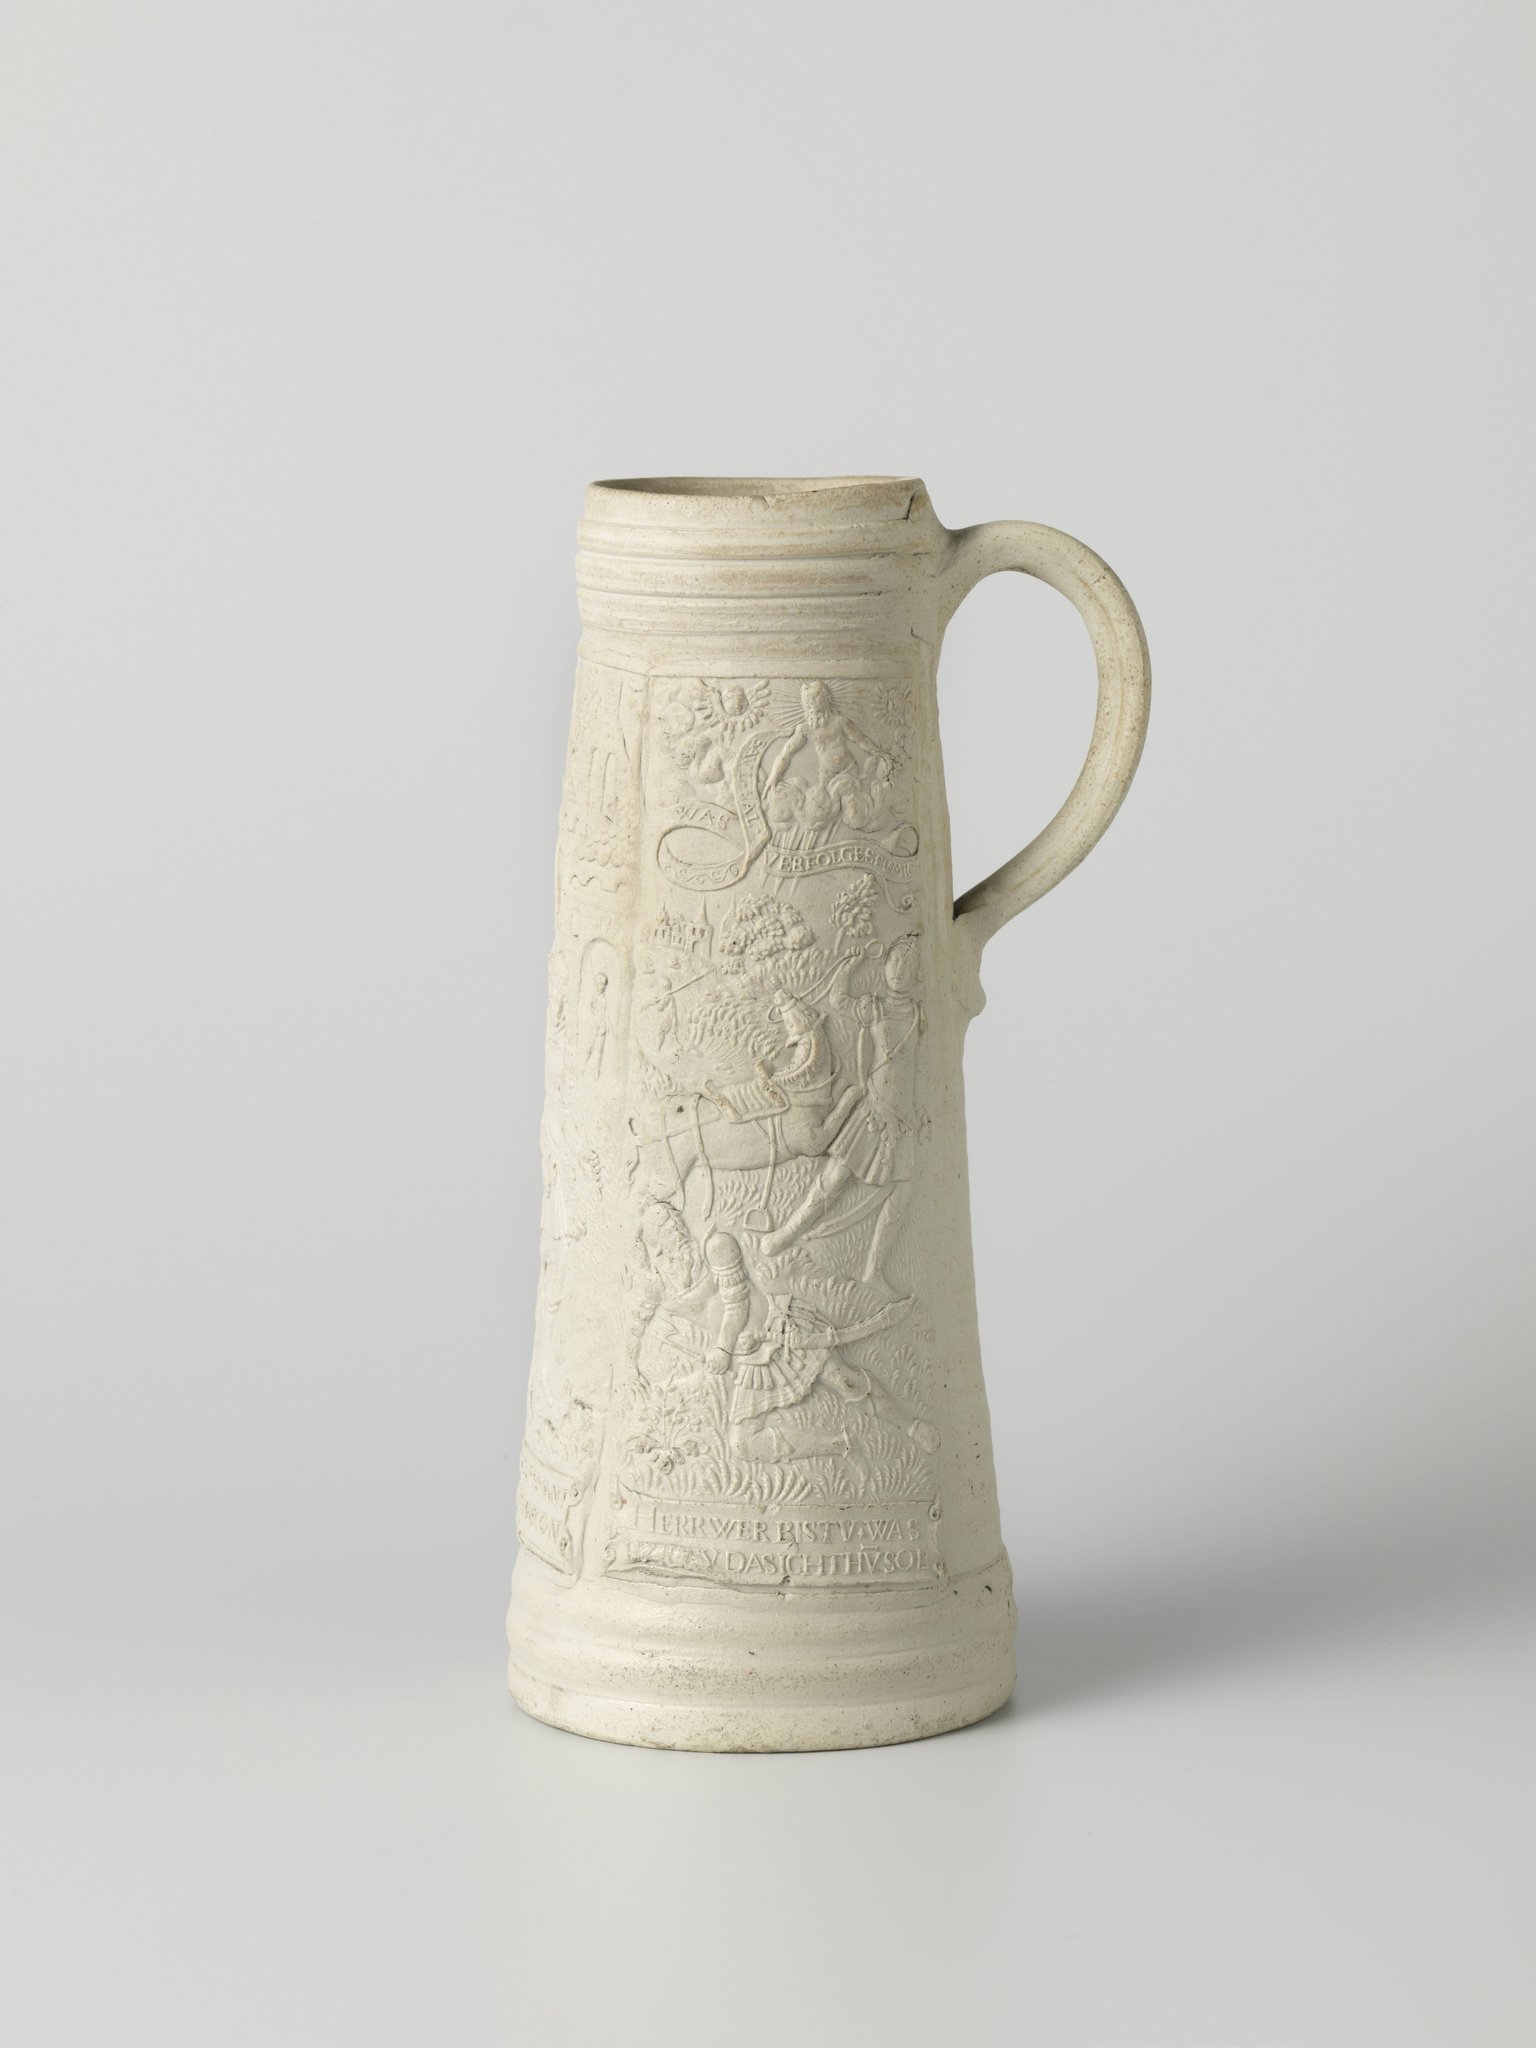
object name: jug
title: Fragment of a tankard (schnelle) with the Conversion of Paul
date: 1560-1565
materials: glaze, stoneware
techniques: firing, forming, relief, turning, vitrification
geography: siegburg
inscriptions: inscription: ‘HERR WER BISTV WAS WILTV DAS ICH THV SOL/ SAVL SAL WAS VERFOLGESTV MICH/ SIE NAME IN BEI DER HANT VD FVRETE INGE DAMASCON’, mark: ‘FT’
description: Fragment van een kruik (schnelle) van steengoed met cilindervormig, taps toelopend lichaam en C-vormig oor. Profielen onder de rand en boven de voet. Op het lichaam in reliëf driemaal een gedrukt en opgelegd, langwerpig vak met daarin voorstellingen van de bekering van Paulus, waarvan de twee buitenste gelijk zijn. De twee buitenste vakken met de opschriften 'HERR WER BISTV WAS WILTV DAS ICH THV SOL' en 'SAVL SAL WAS VERFOLGESTV MICH'. Het middelste vak met 'SIE NAME IN BEI DER HANT VD FVRETE INGE DAMASCON'. In elk vak het merk 'F.T.'. Siegburg.